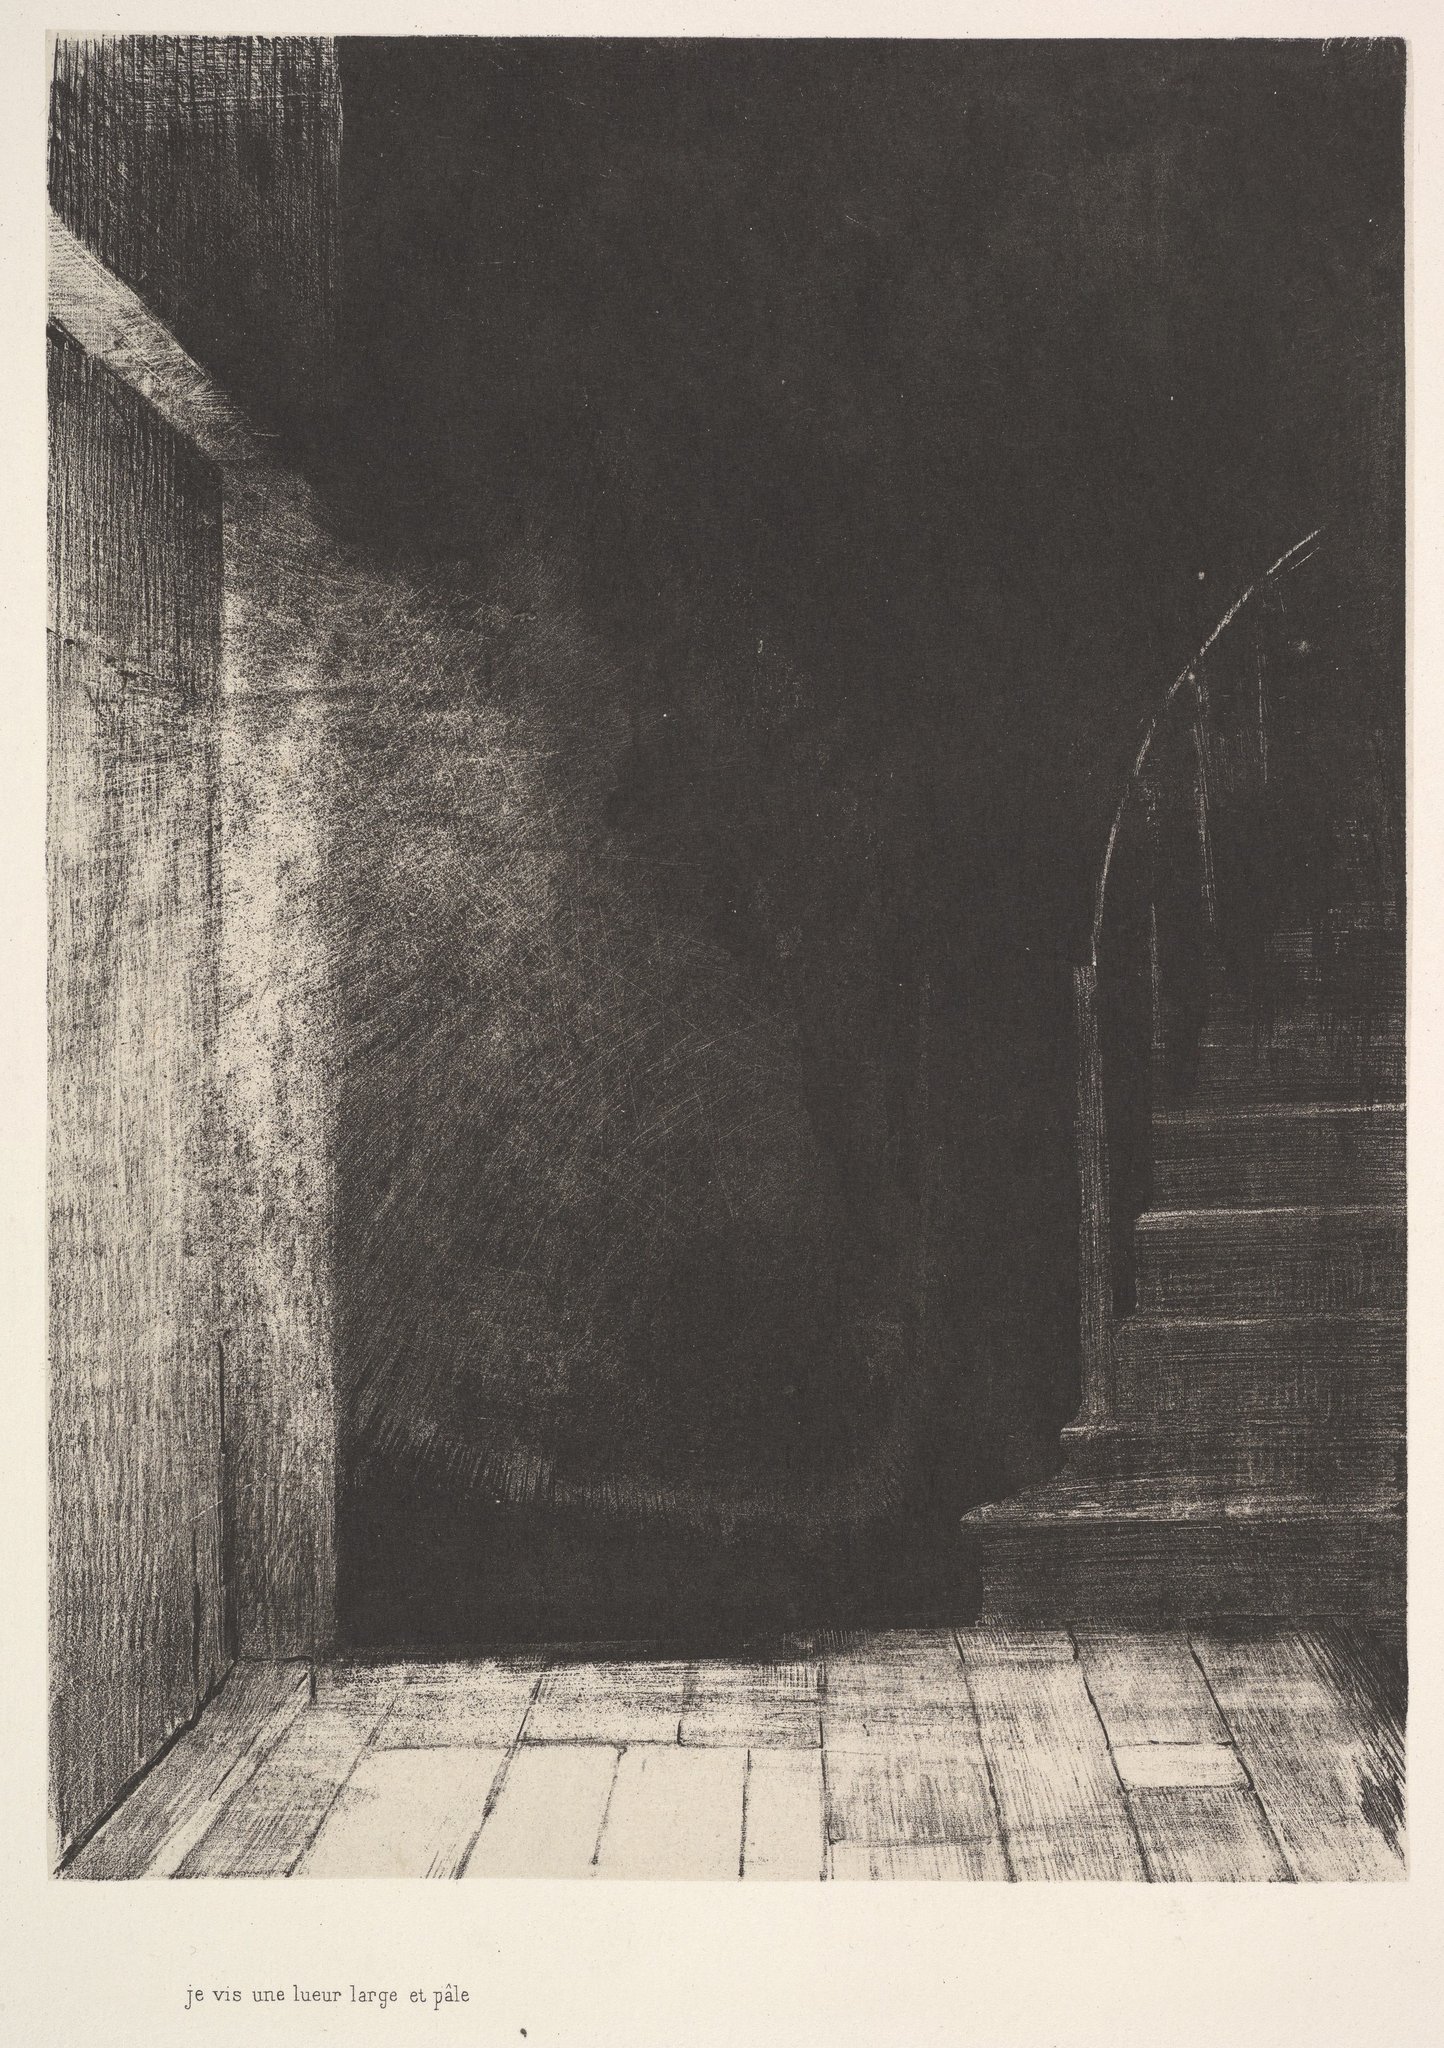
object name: print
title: I saw a flash of light, large and pale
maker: odilon redon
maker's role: artist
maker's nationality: french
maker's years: 1840-1916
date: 1896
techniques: lithograph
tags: stairs,interiors